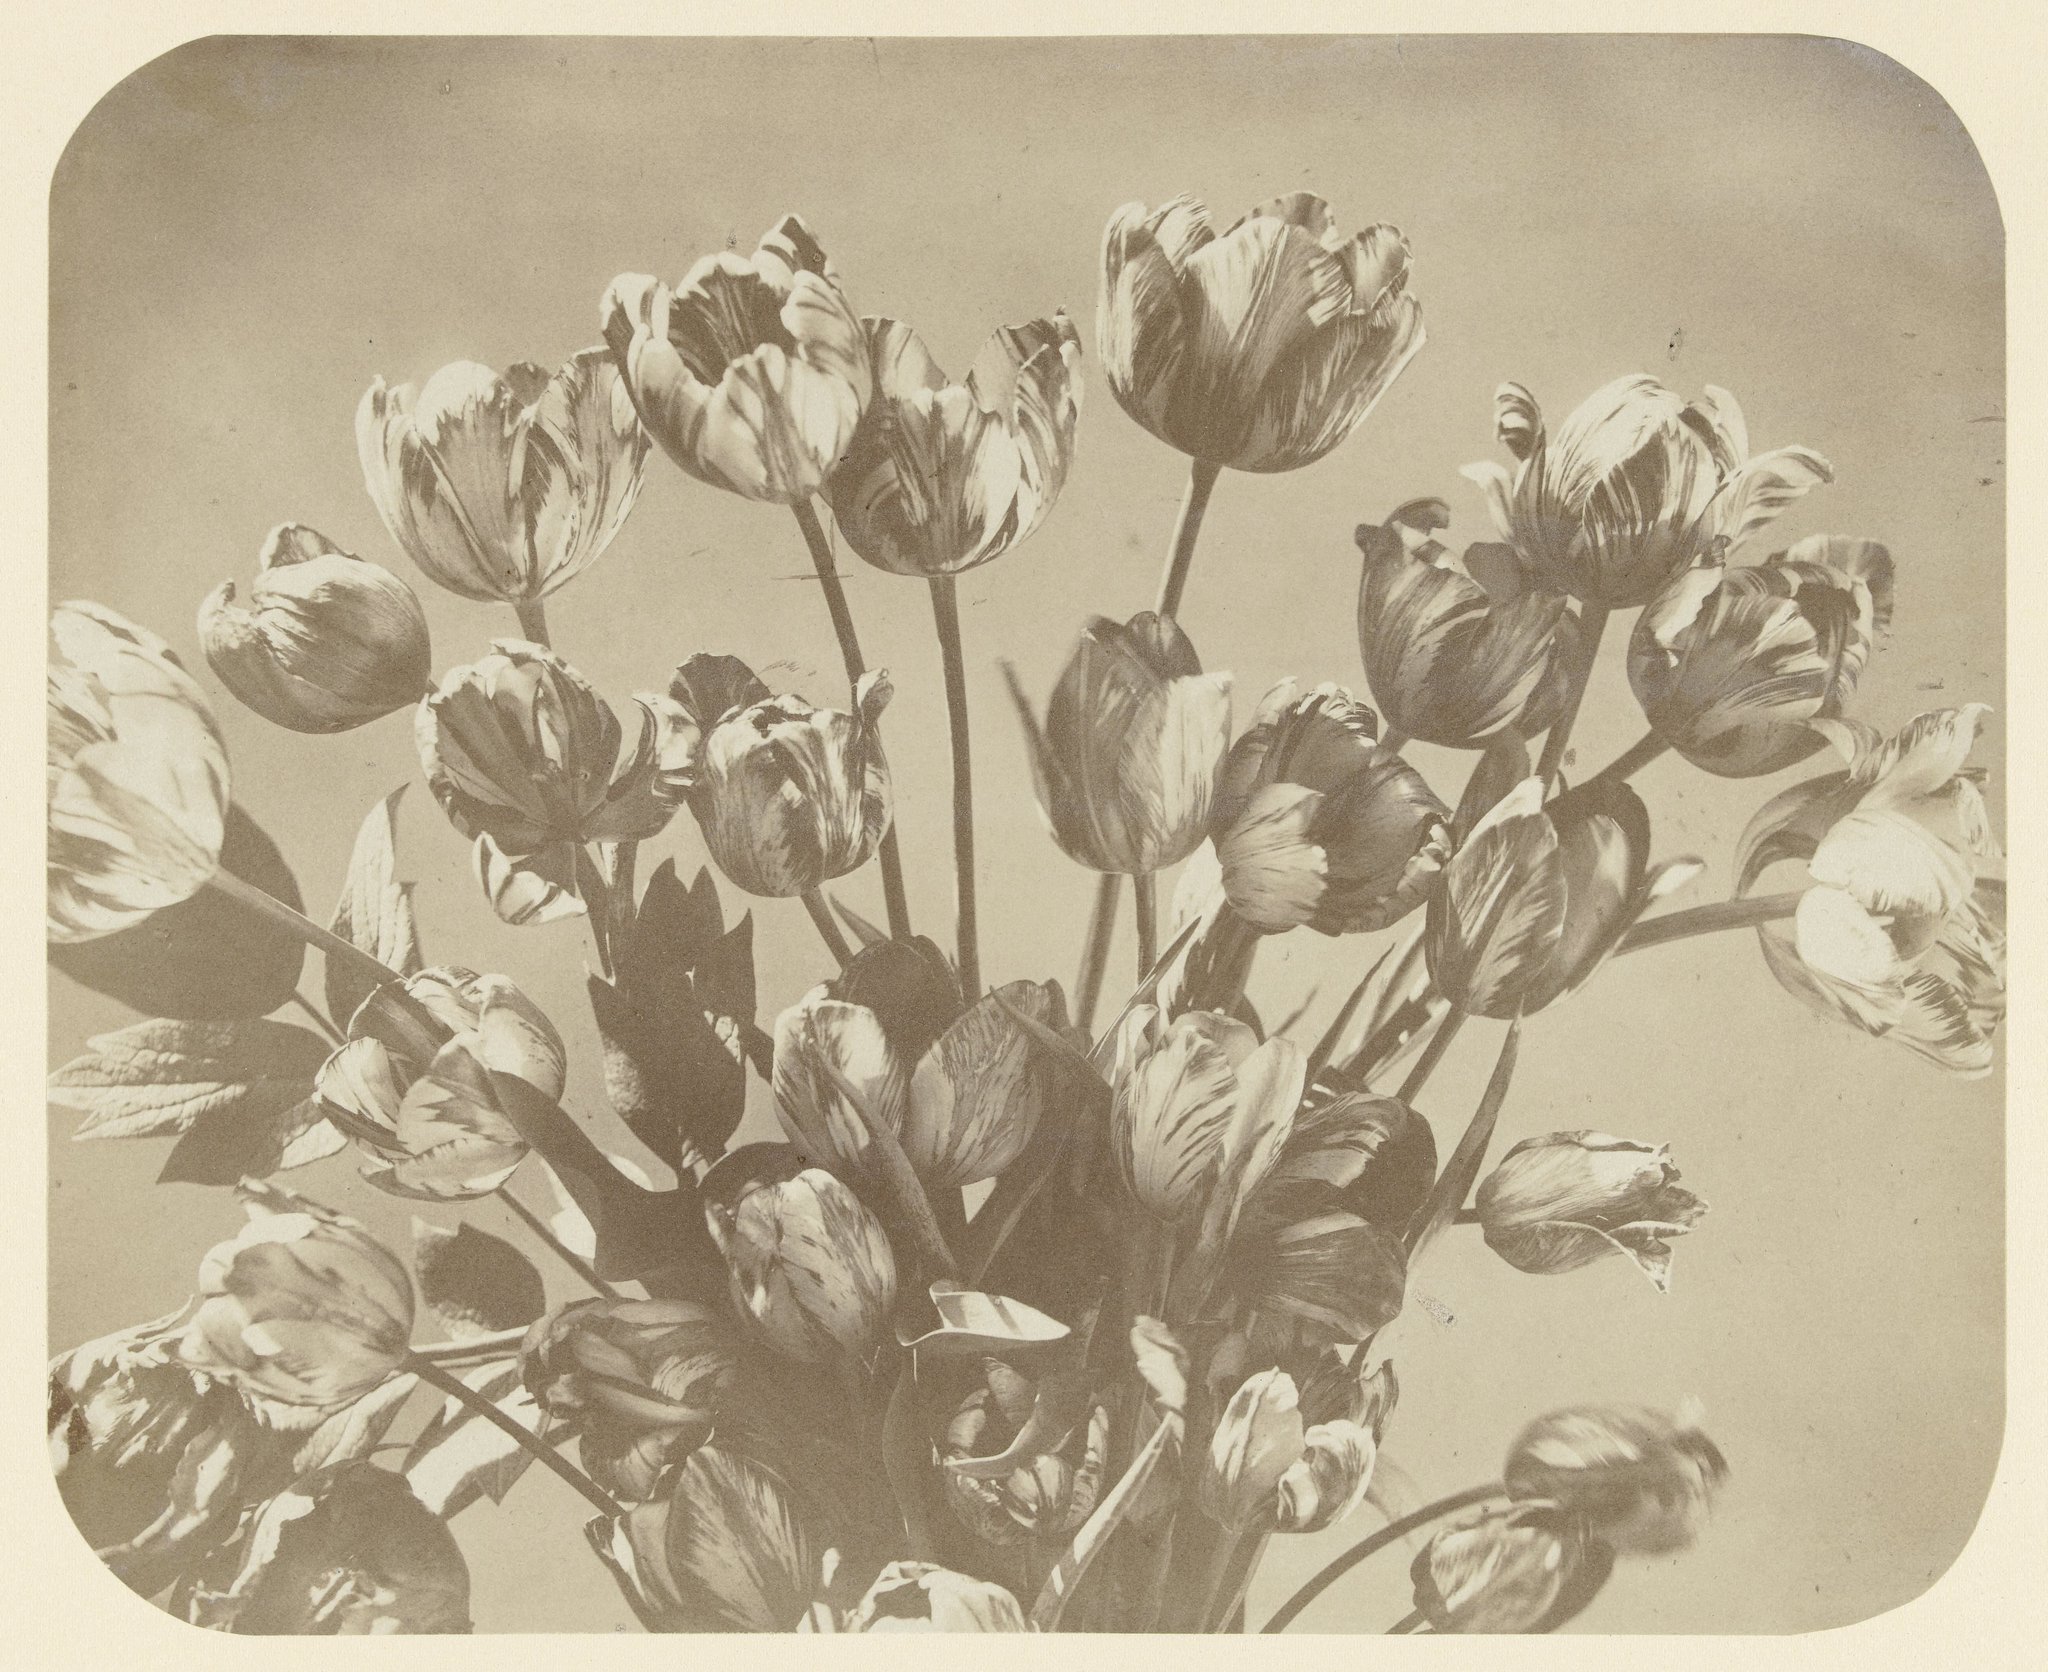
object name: photograph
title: Stilleven van een boeket tulpen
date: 1857-1860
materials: paper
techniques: albuminized salt print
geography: dornach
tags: flowers: tulip